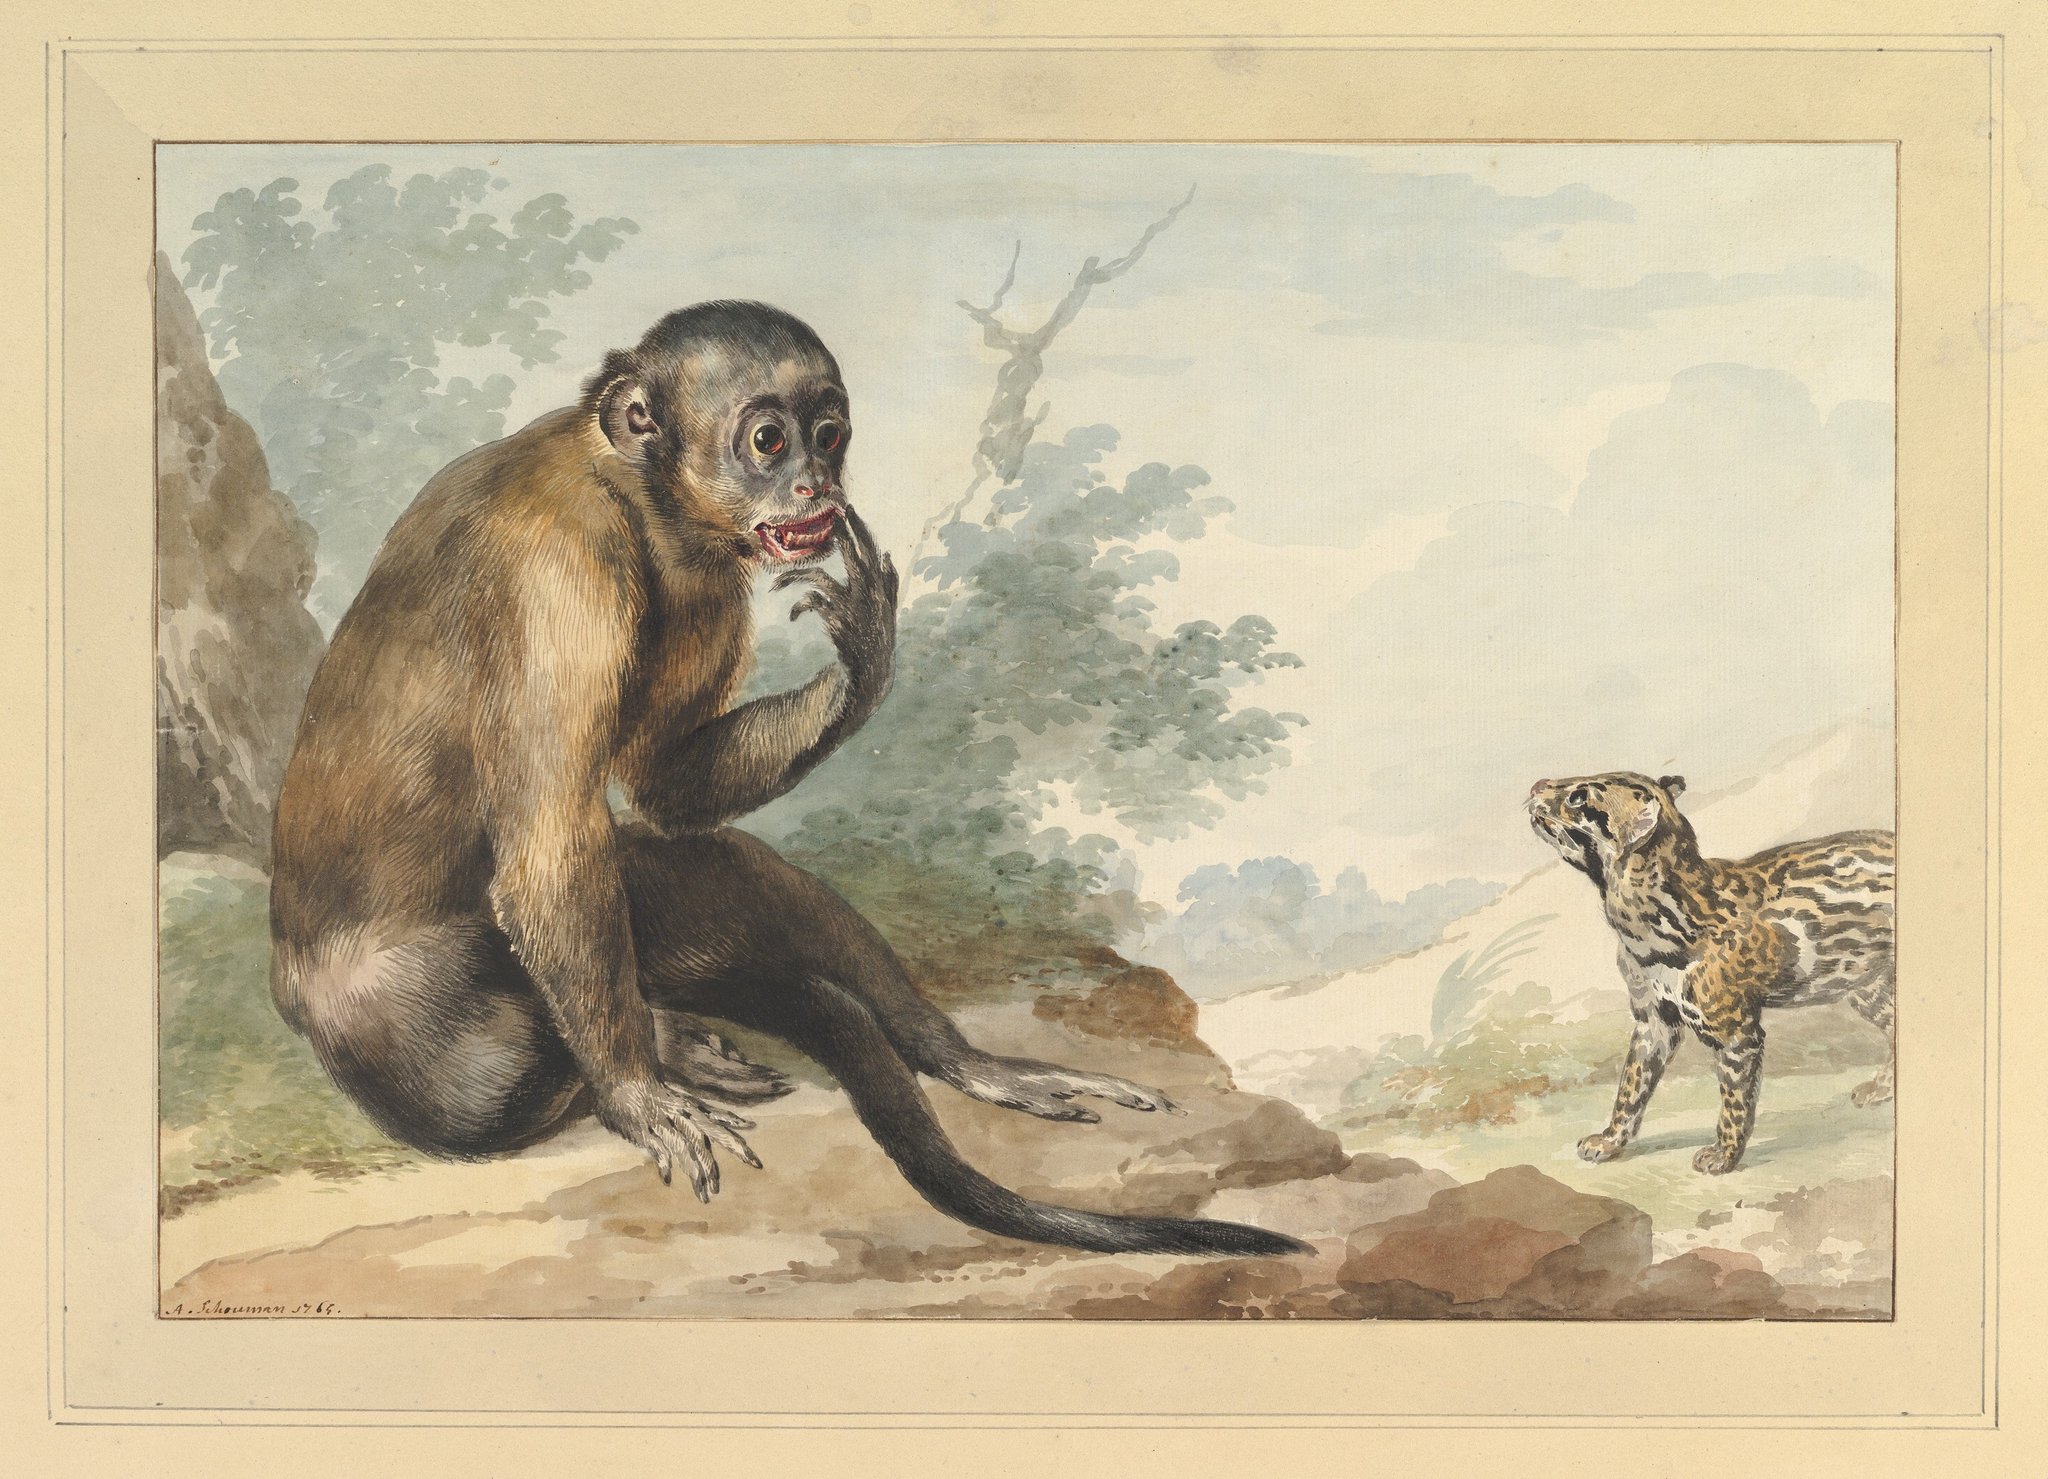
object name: drawing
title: A Monkey Sitting on a Rock Looking at a Civet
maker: aert schouman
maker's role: artist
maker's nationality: netherlandish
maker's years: 1710-1792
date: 1764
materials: chalk, watercolor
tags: monkeys